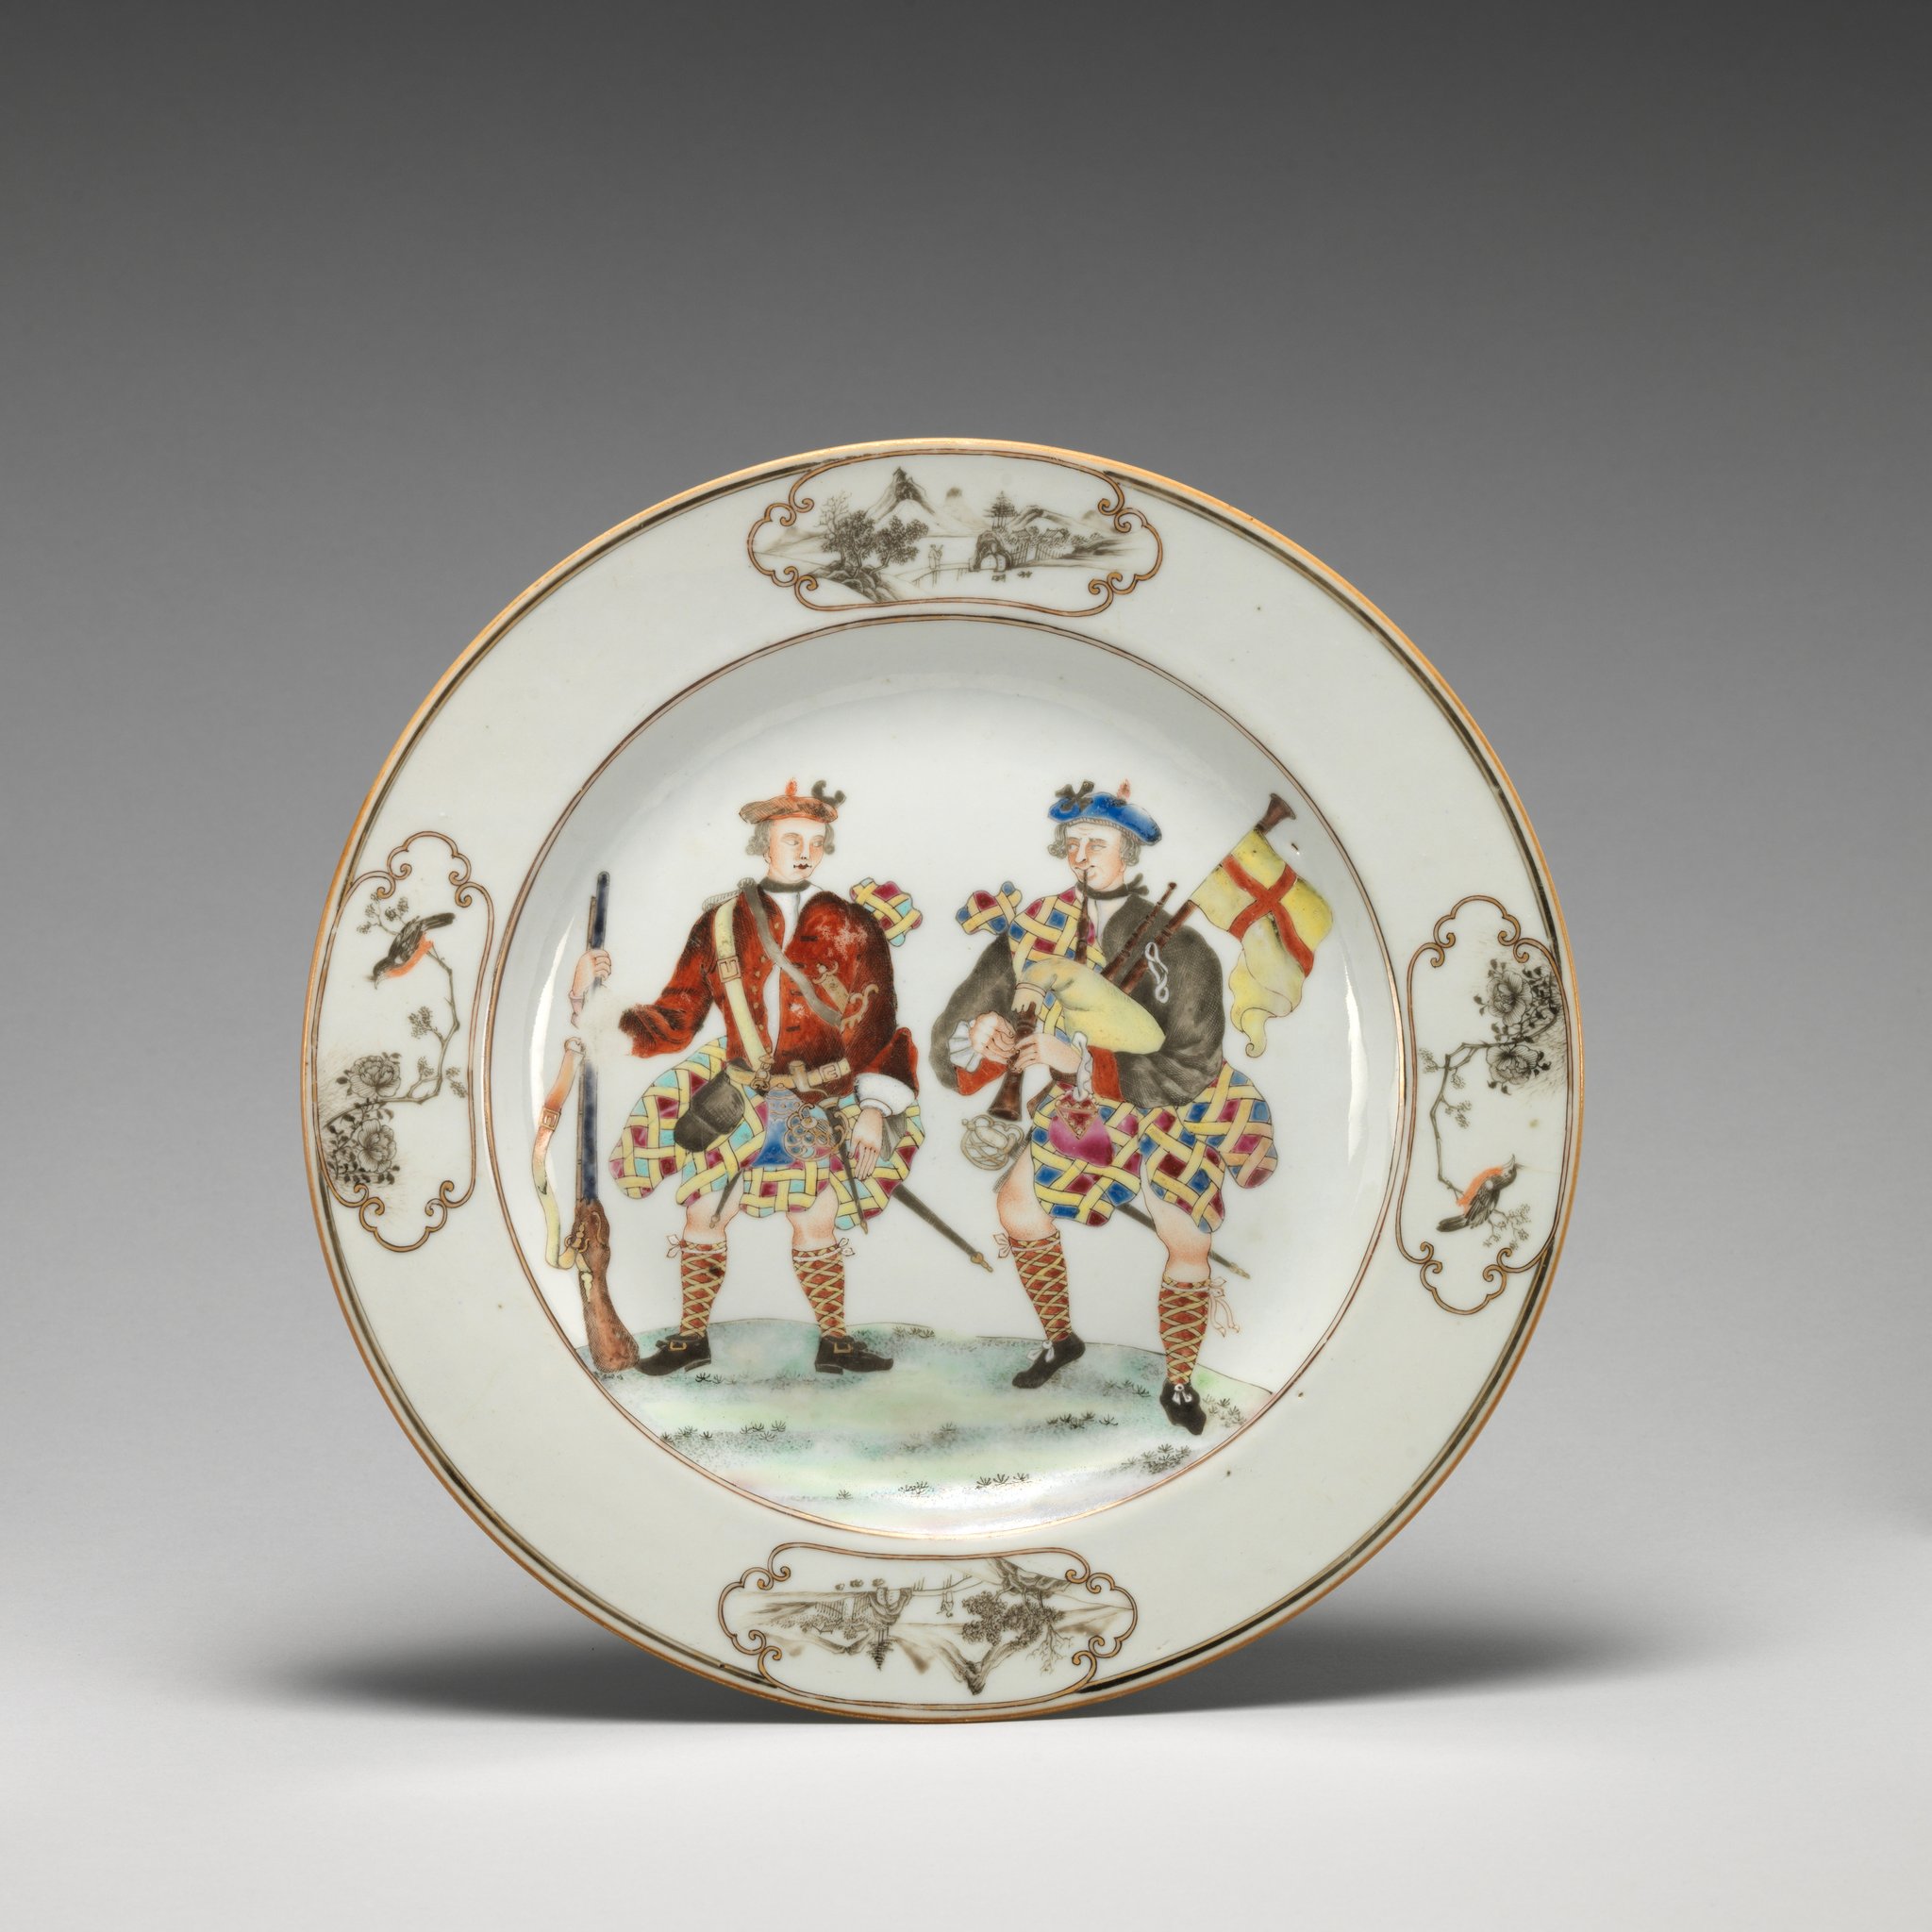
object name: plate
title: Plate (one of a pair)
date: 1734-1766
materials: hard paste porcelain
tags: firearms,men,bagpipes